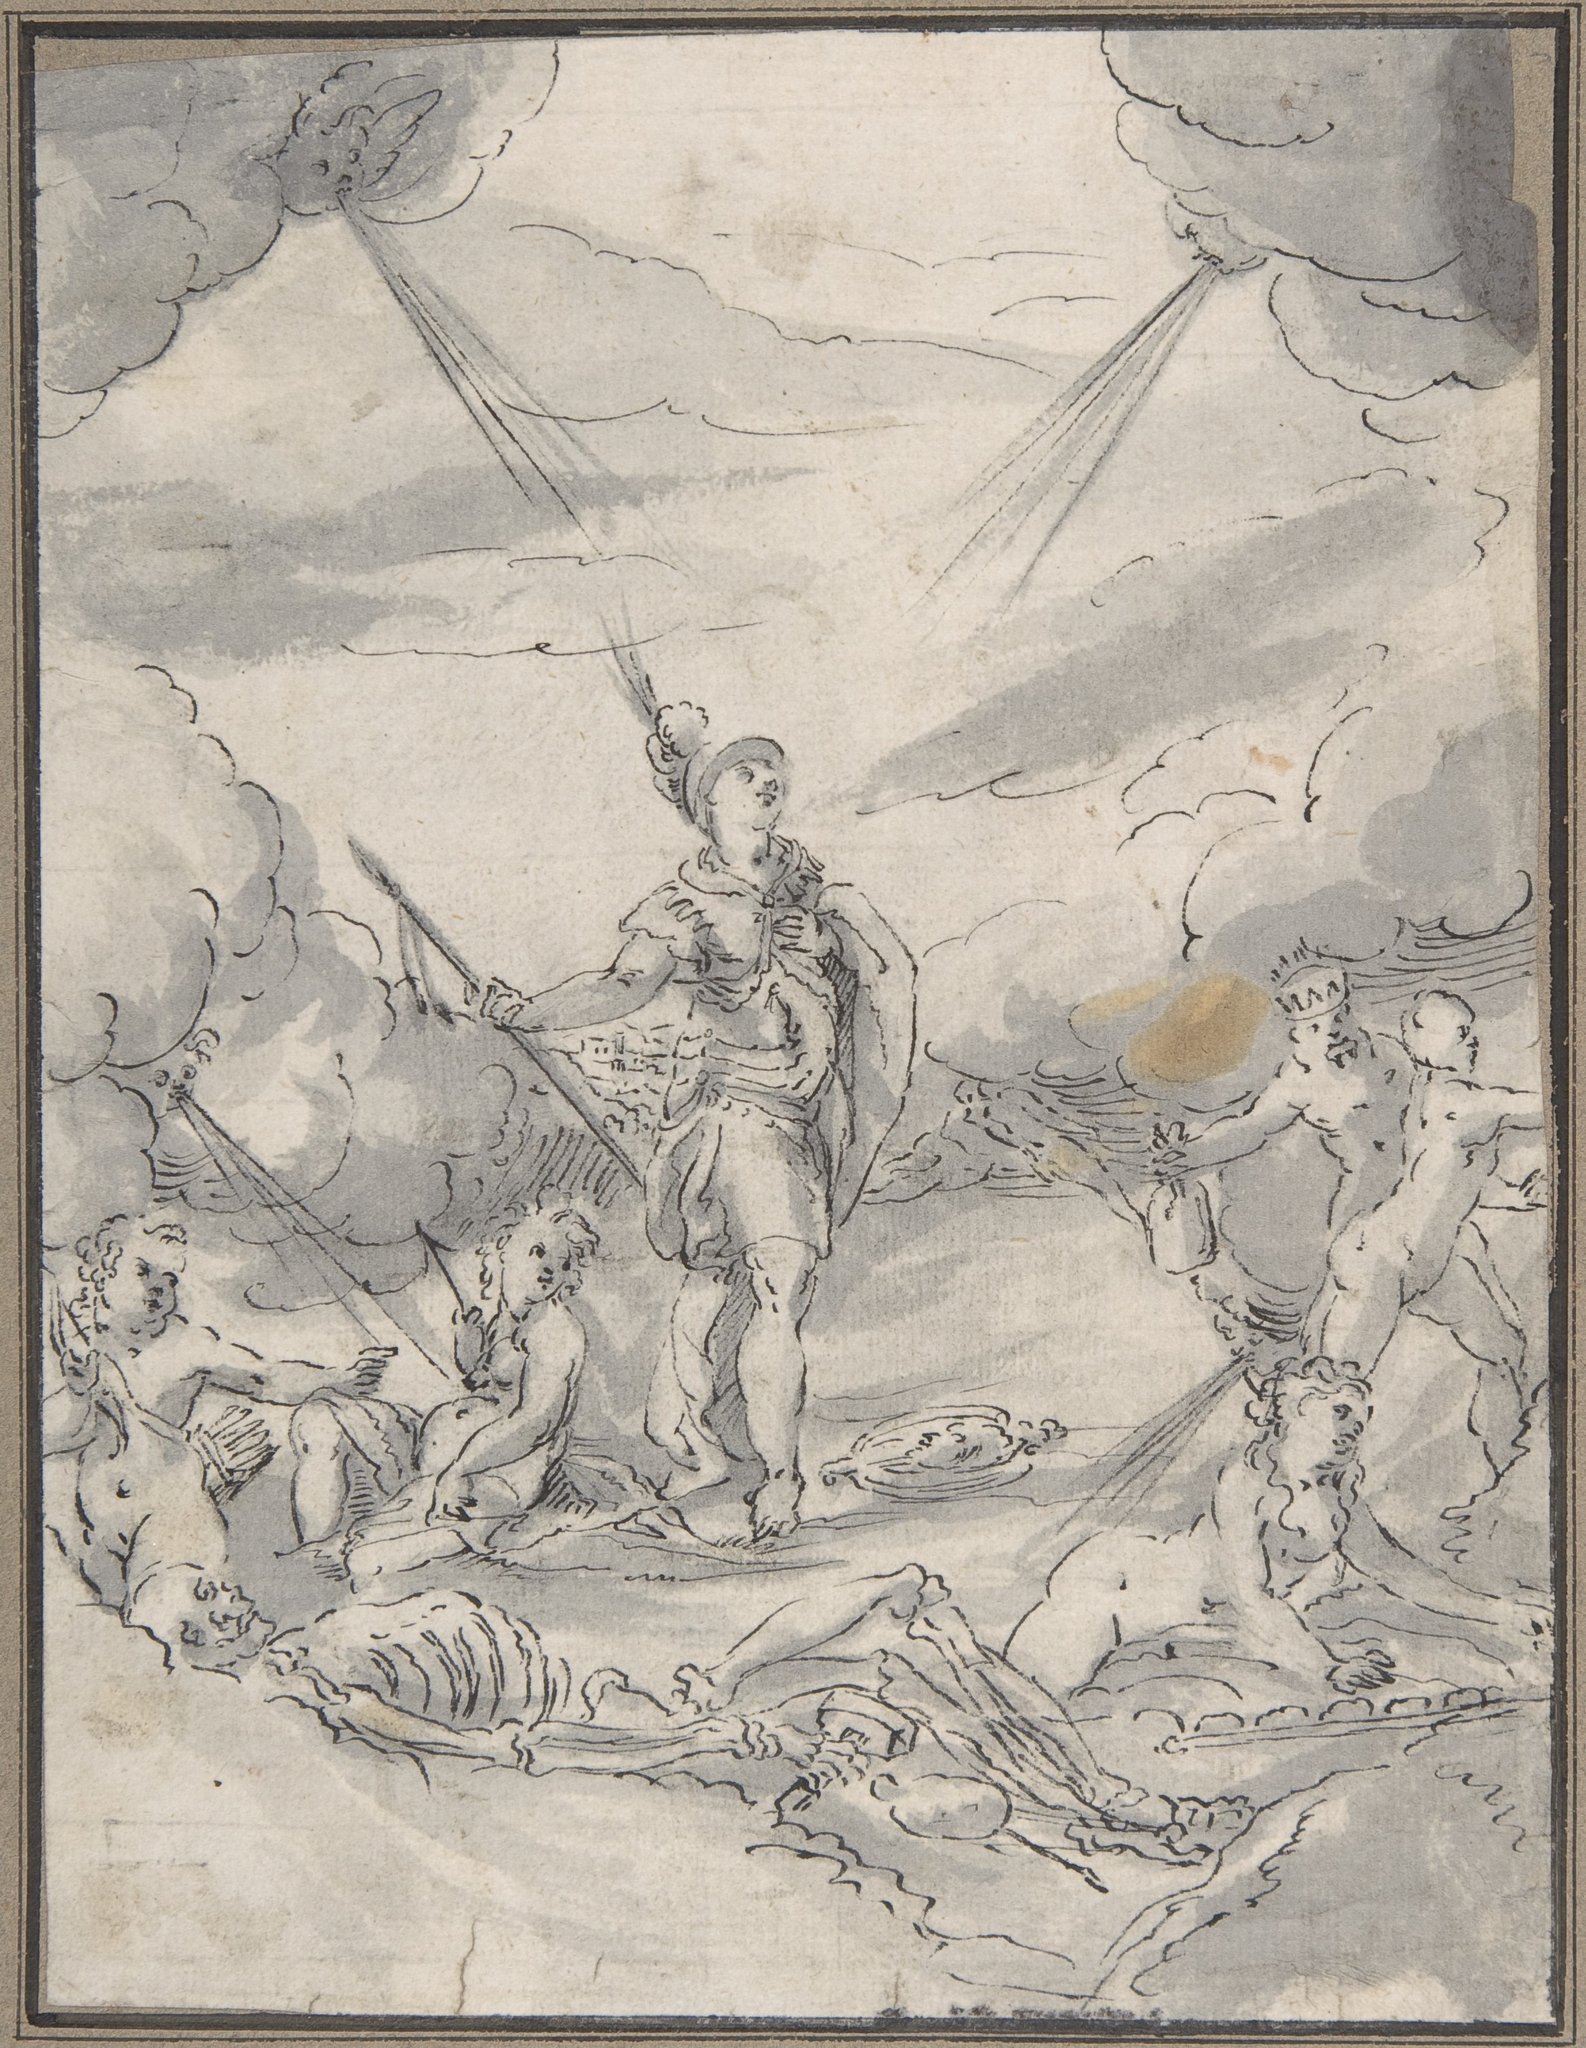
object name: drawing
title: Allegorical Scene (Temptations of a Wealthy Man?)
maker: master of the stockholm wolf huber copies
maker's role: artist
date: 1601-1650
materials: ink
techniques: brush, pen, wash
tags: spears,skeletons,men,female nudes